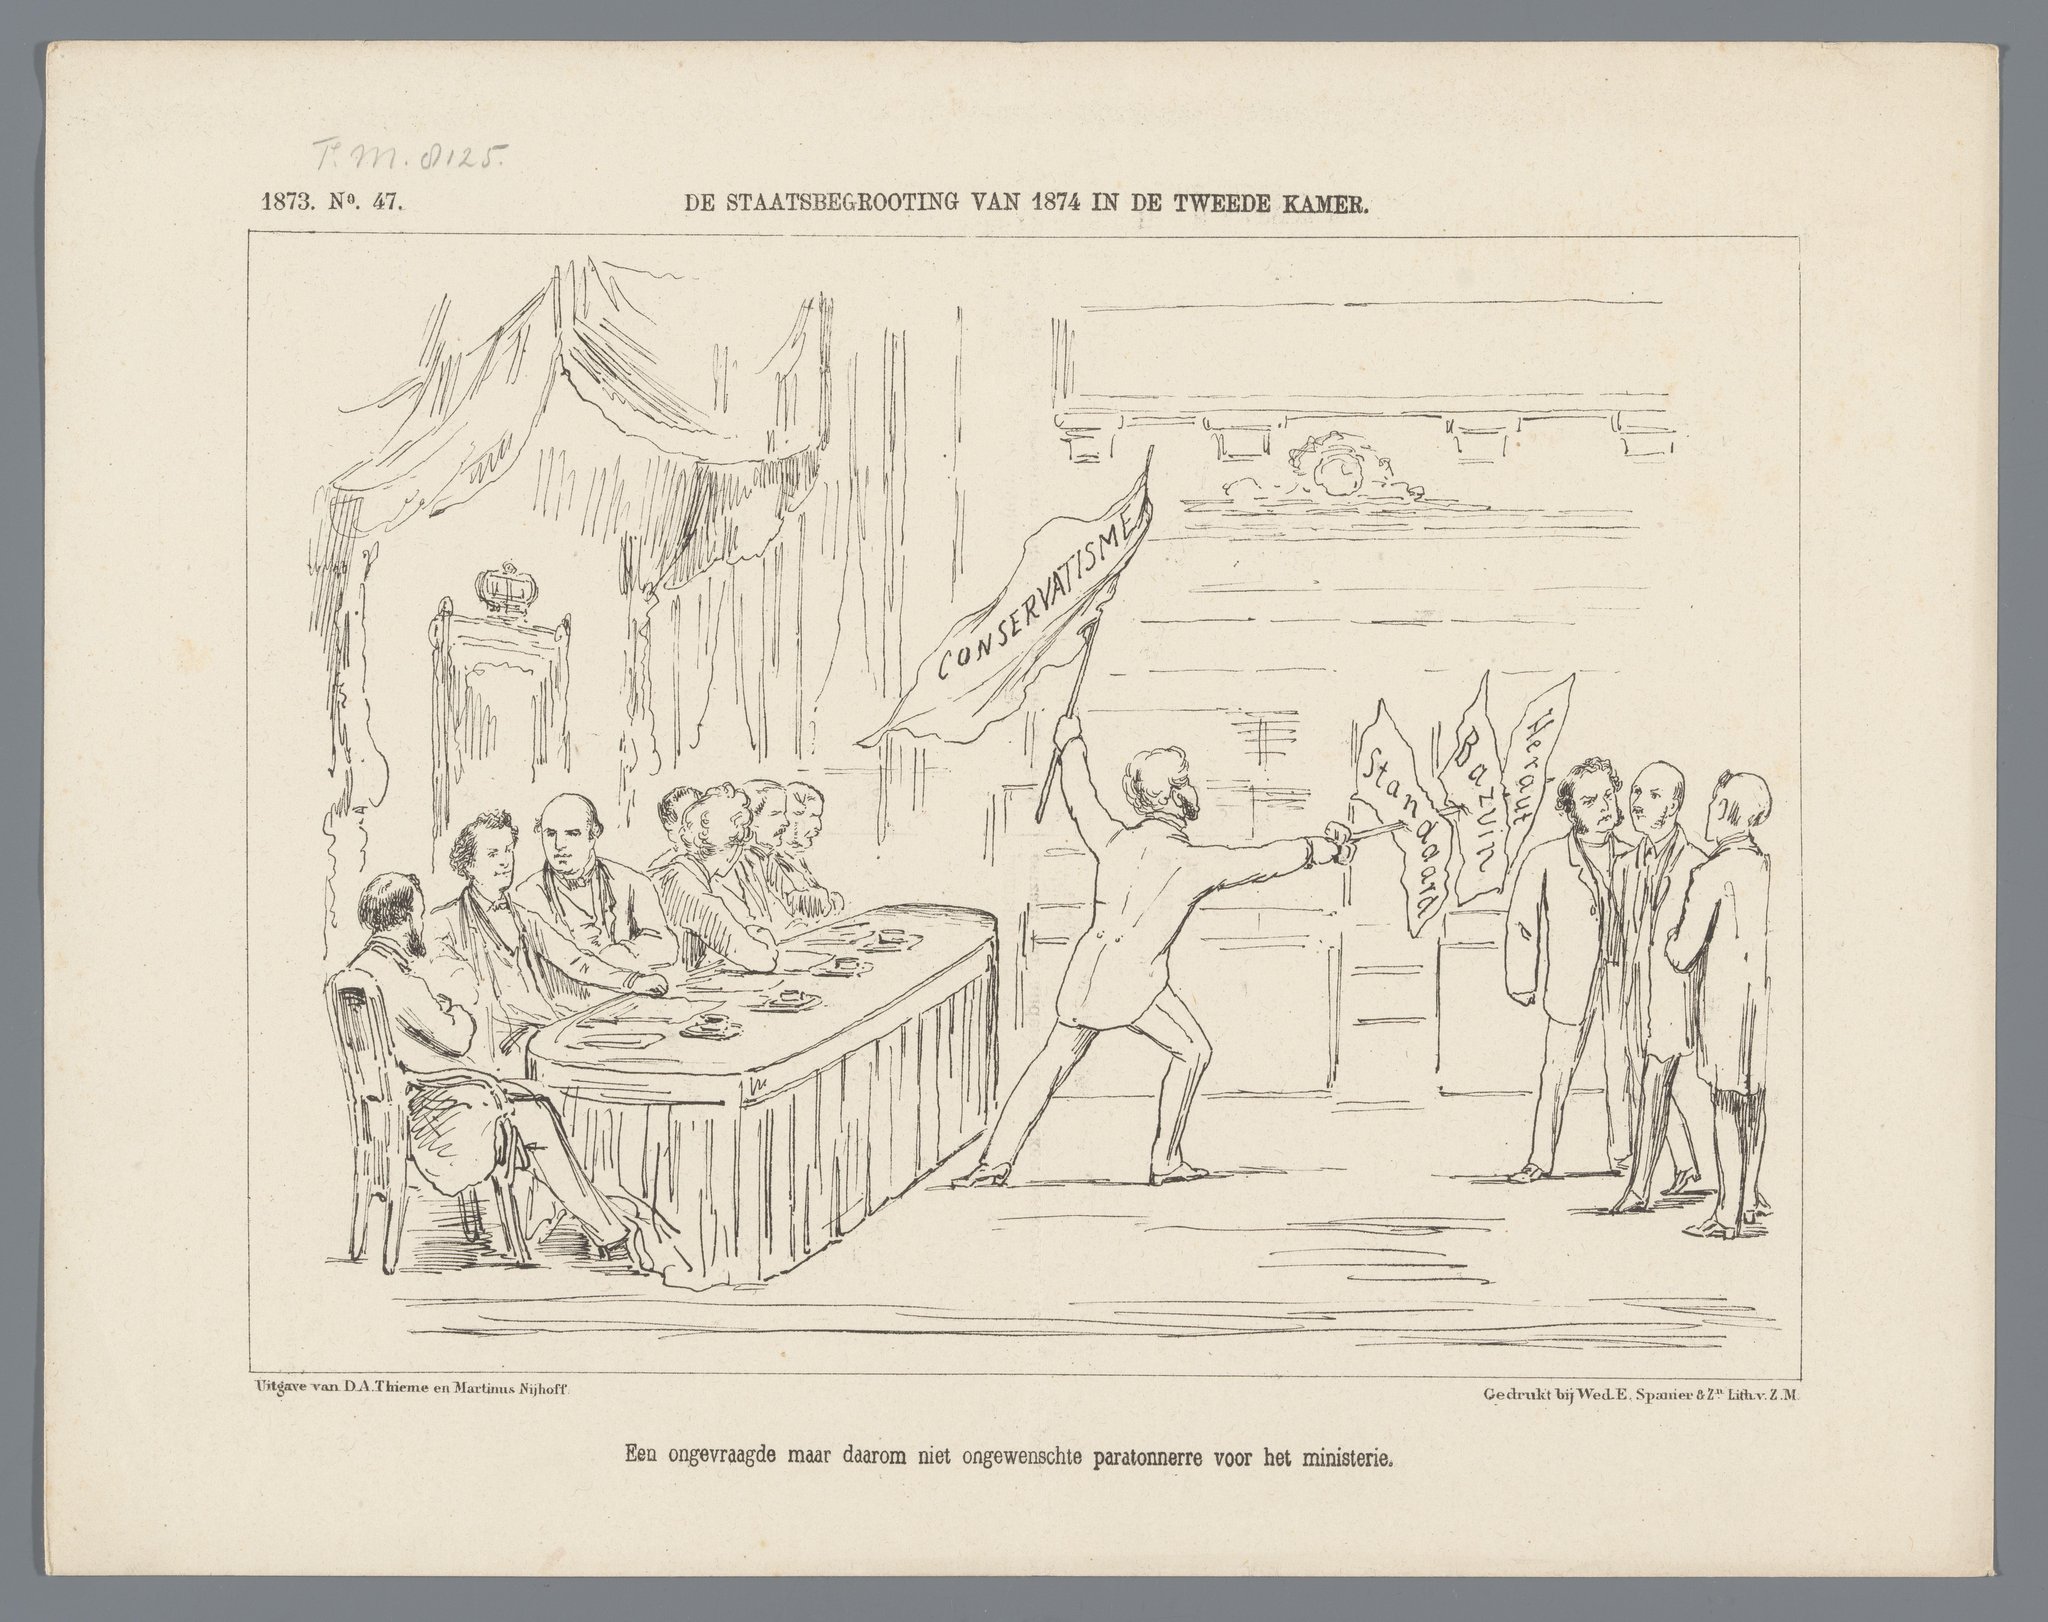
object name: print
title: Spotprent op de aanval van Wintgens op de antirevolutionairen, 1873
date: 1873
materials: paper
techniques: lithograph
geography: the hague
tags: politician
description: Spotprent op de felle aanval van Wintgens op 17 november op de antirevolutionairen. Plaat verschenen bij het weekblad De Nederlandsche Spectator, nr. 47, 1873.